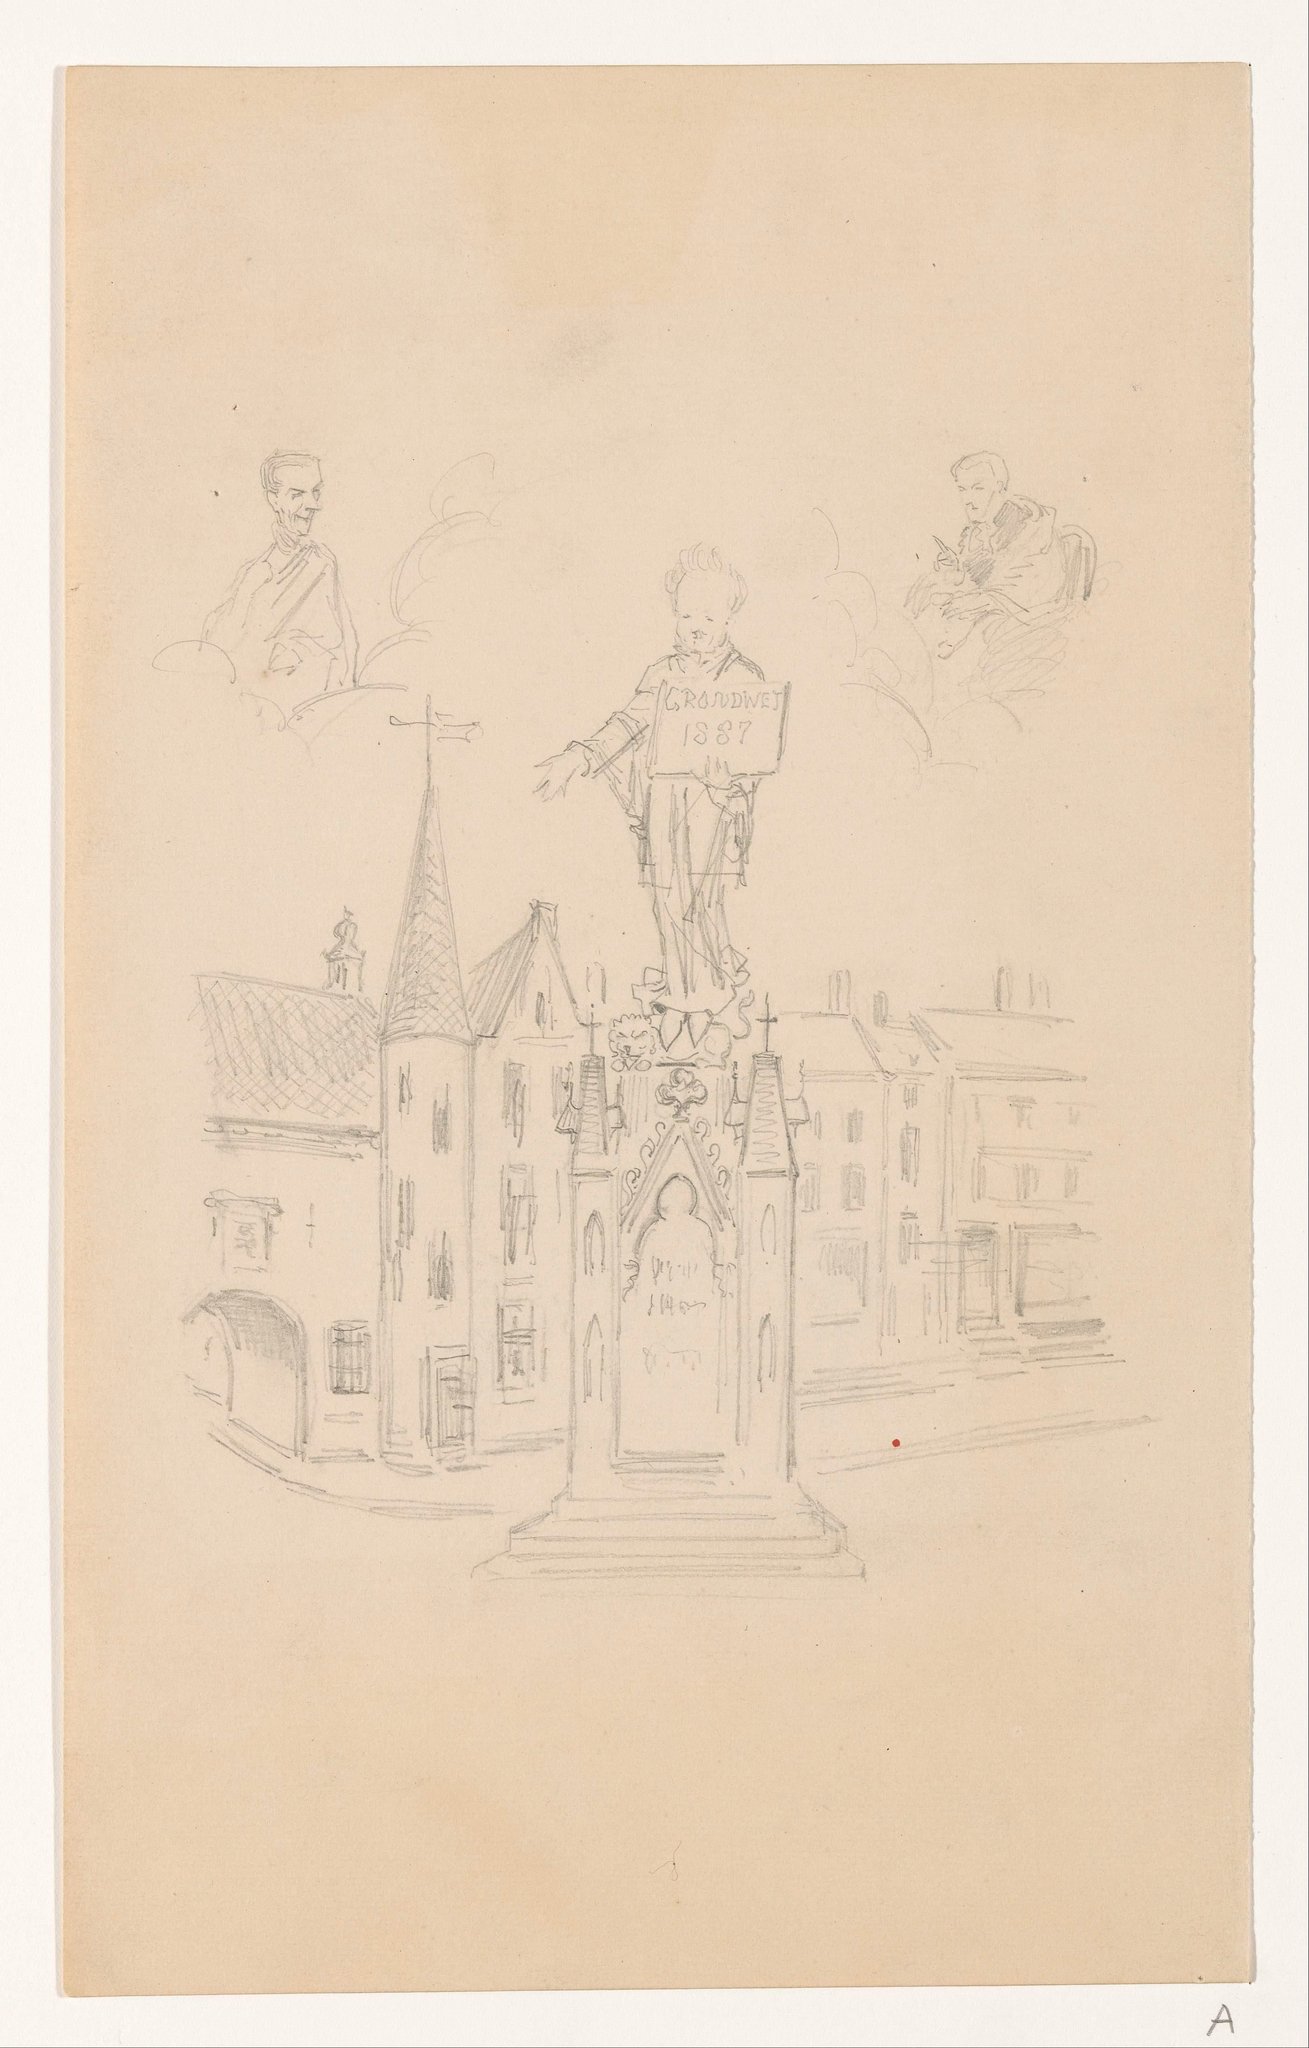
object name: drawing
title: Grondwetsherziening van 1887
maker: johan michaël schmidt crans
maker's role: draughtsman, print maker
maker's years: 1830-1907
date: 1887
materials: paper, pencil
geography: netherlands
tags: johan rudolf thorbecke, gijsbert karel graaf van hogendorp, amsterdam, politician, political caricatures and satires, netherlands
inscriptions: inscription: ‘De Nederlandsche Spectator 1887 no 46 ro p. 382.’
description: Schets voor een spotprent in De Nederlandsche Spectator nr. 46 van 1887, naar aanleiding van de aangenomen Grondwetsherziening met het Caoutchouc-artikel. Hogendorp en Thorbecke in de wolken boven het Binnenhof te Den Haag. In het midden een standbeeld van minister Heemskerk met de Grondwet 1887 in zijn linkerhand.